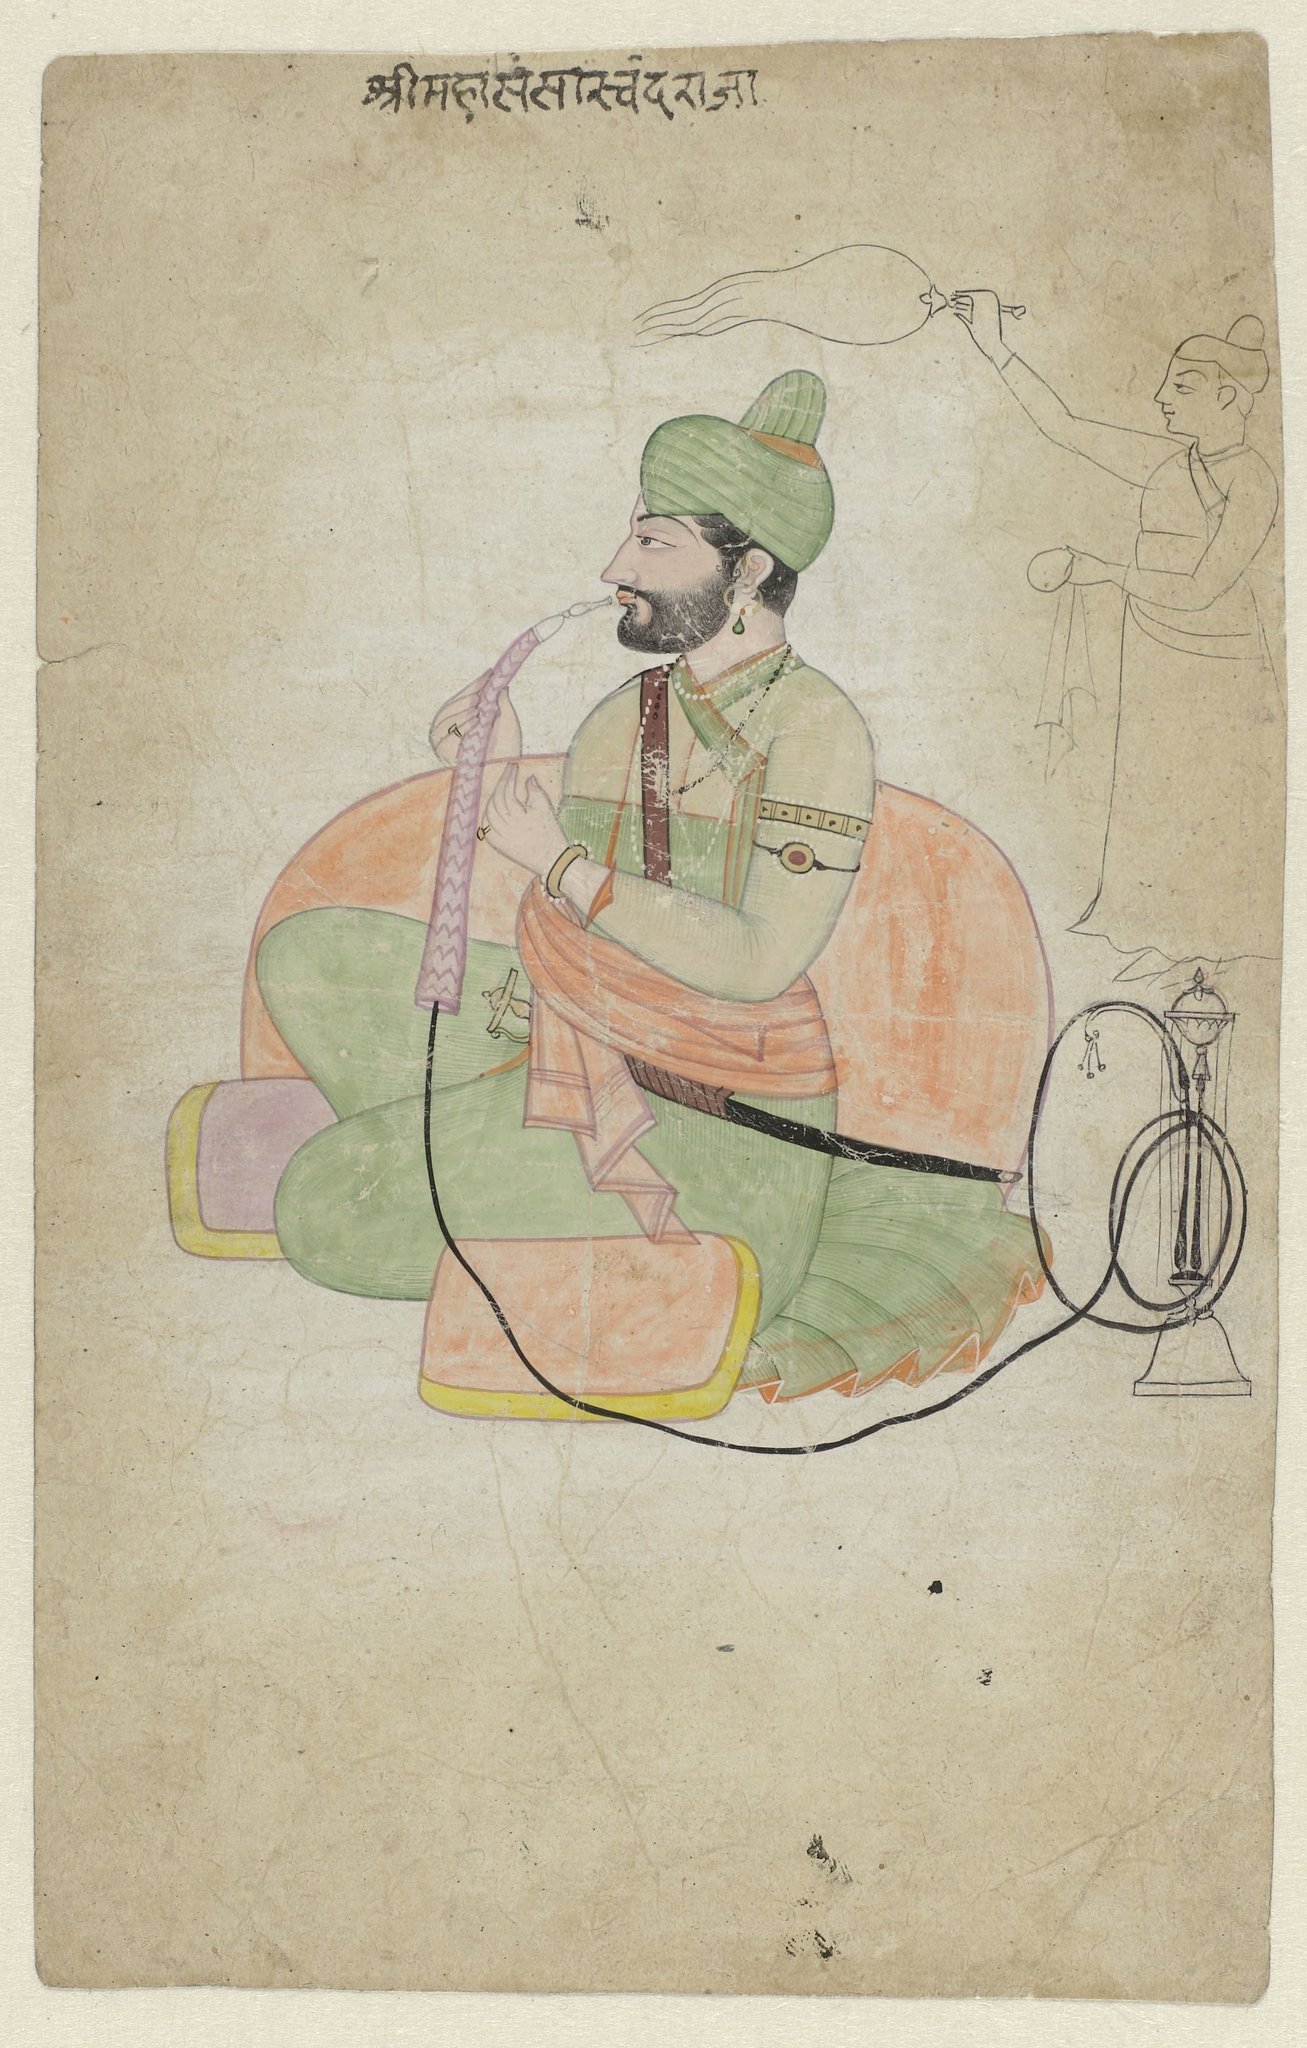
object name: indian miniature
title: Portret van Sansar Chand, postuum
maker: Anonymous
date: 1830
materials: paper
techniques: brush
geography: kangra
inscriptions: inscription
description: Op een waaiervormig kleedje zit een waterpijprokende sultan; een dienaar achter hem wuift hem koelte toe met een waaier in de rechterhand en houdt in zijn linkerhand een doekje vast. De sultan op zijn kleedje is ingekleurd, de dienaar is slechts in schets aanwezig.